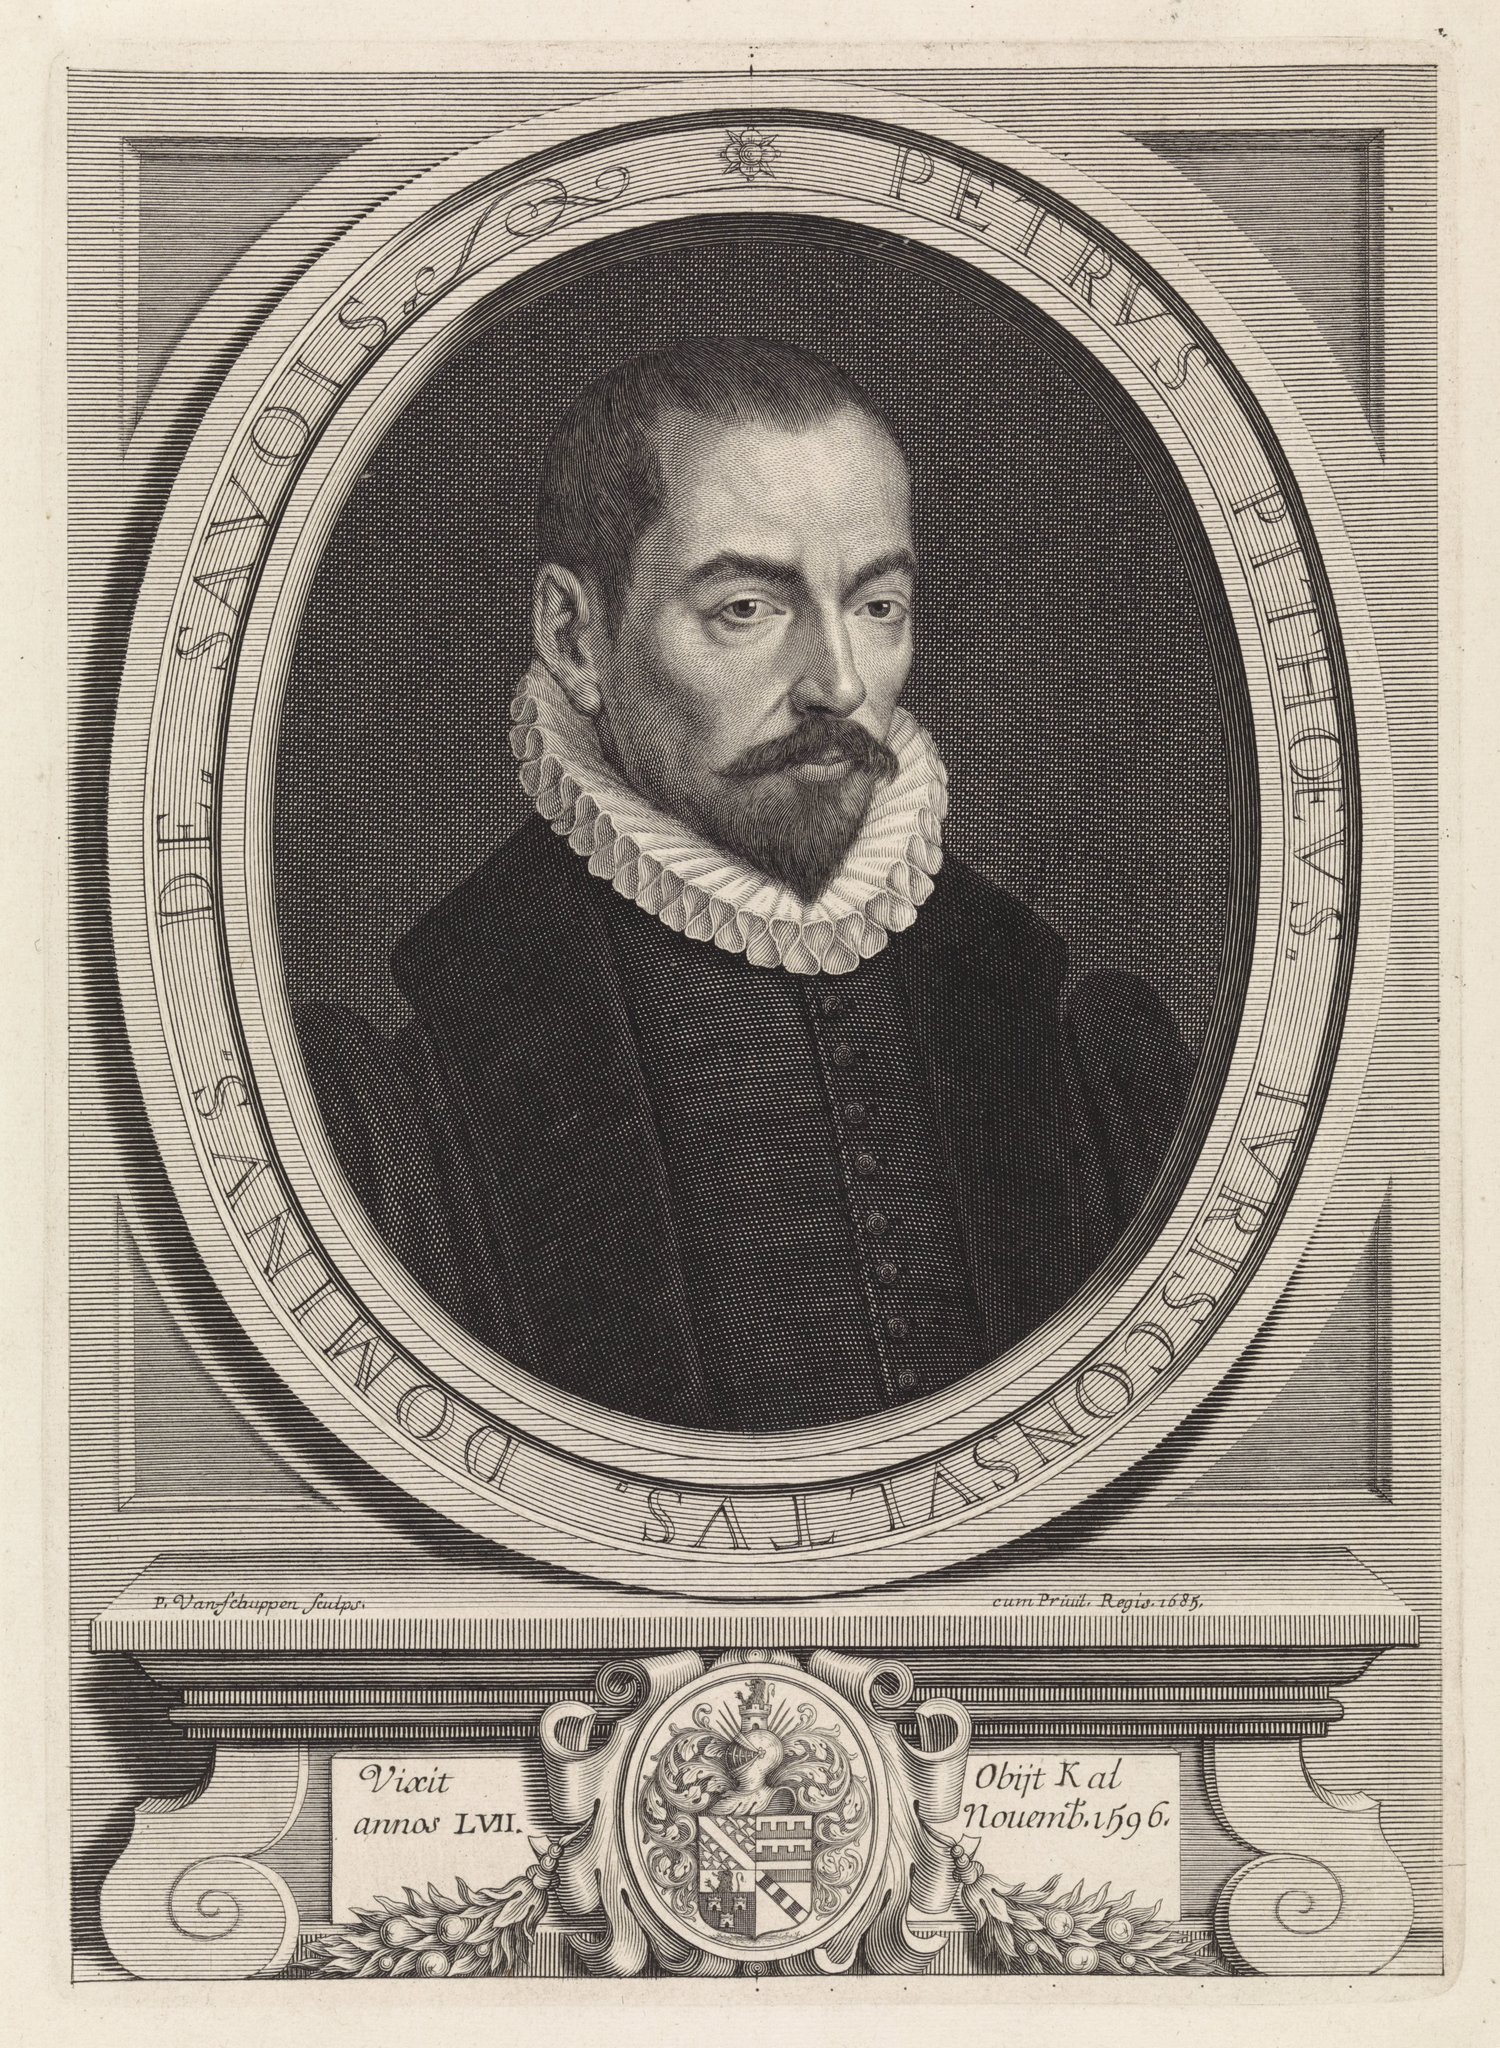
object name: print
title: Portret van de jurist Pierre Pithou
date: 1685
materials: paper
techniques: engraving, etching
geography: paris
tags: troyes, nogent-sur-seine, jurist, filoloog, pierre pithou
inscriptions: date